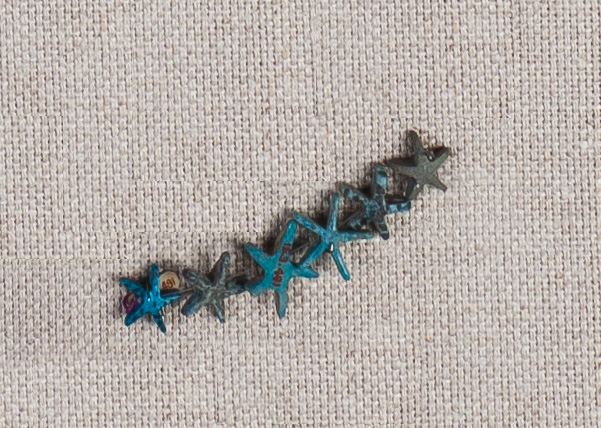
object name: necklace, bead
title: Necklace of amulets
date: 1981-1295 BCE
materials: faience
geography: egypt